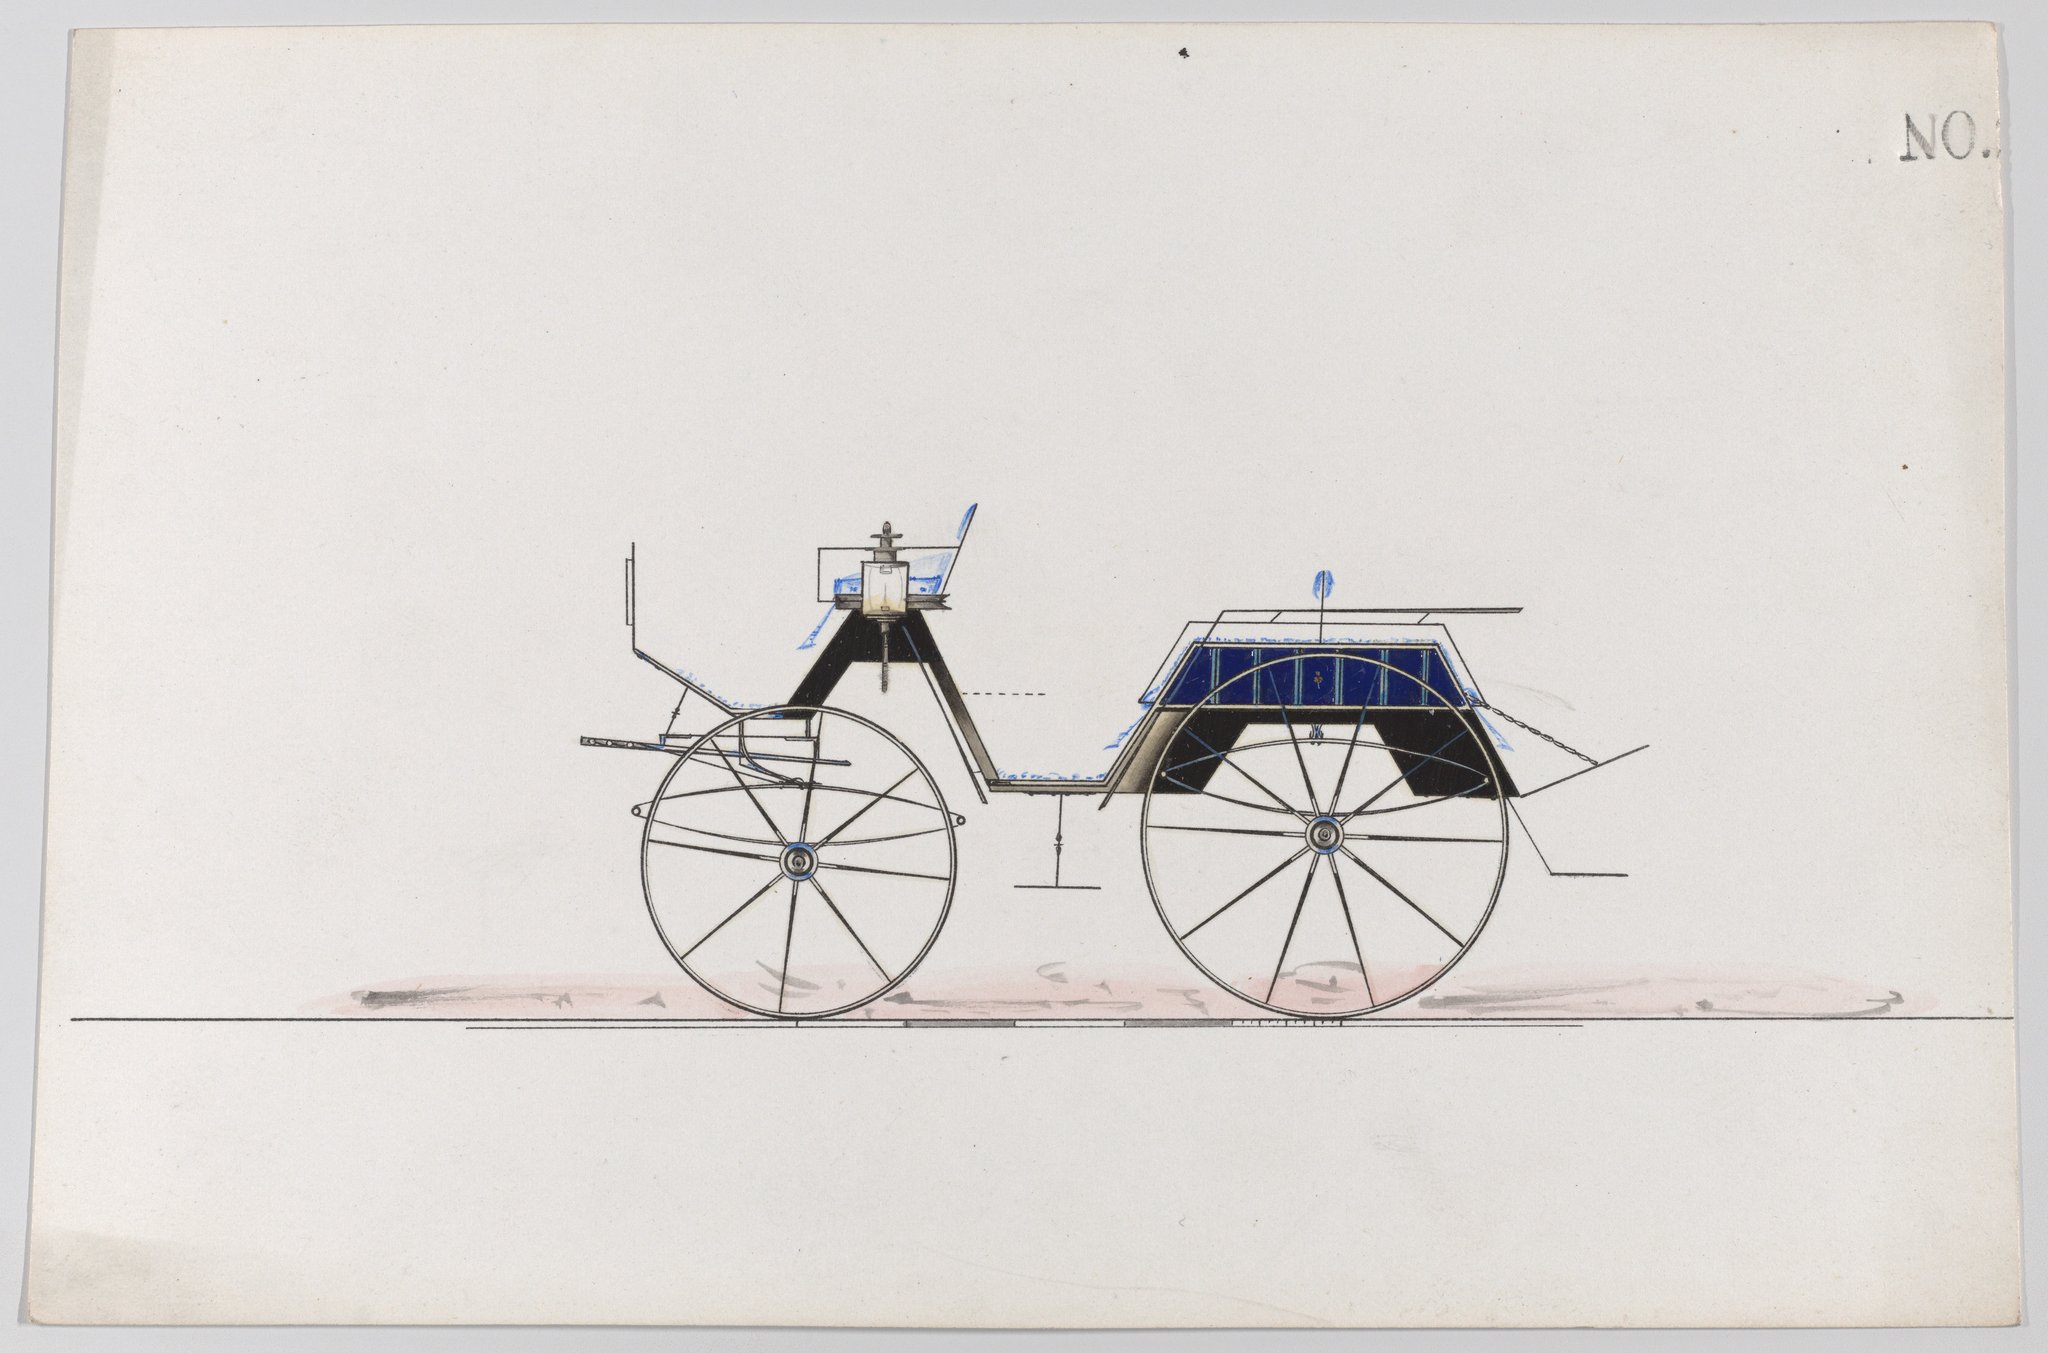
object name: drawing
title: Carriage Design (unnumbered)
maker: brewster & co.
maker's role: manufacturer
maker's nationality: american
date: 1870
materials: gouache, gum arabic, ink, watercolor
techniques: pen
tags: carriages